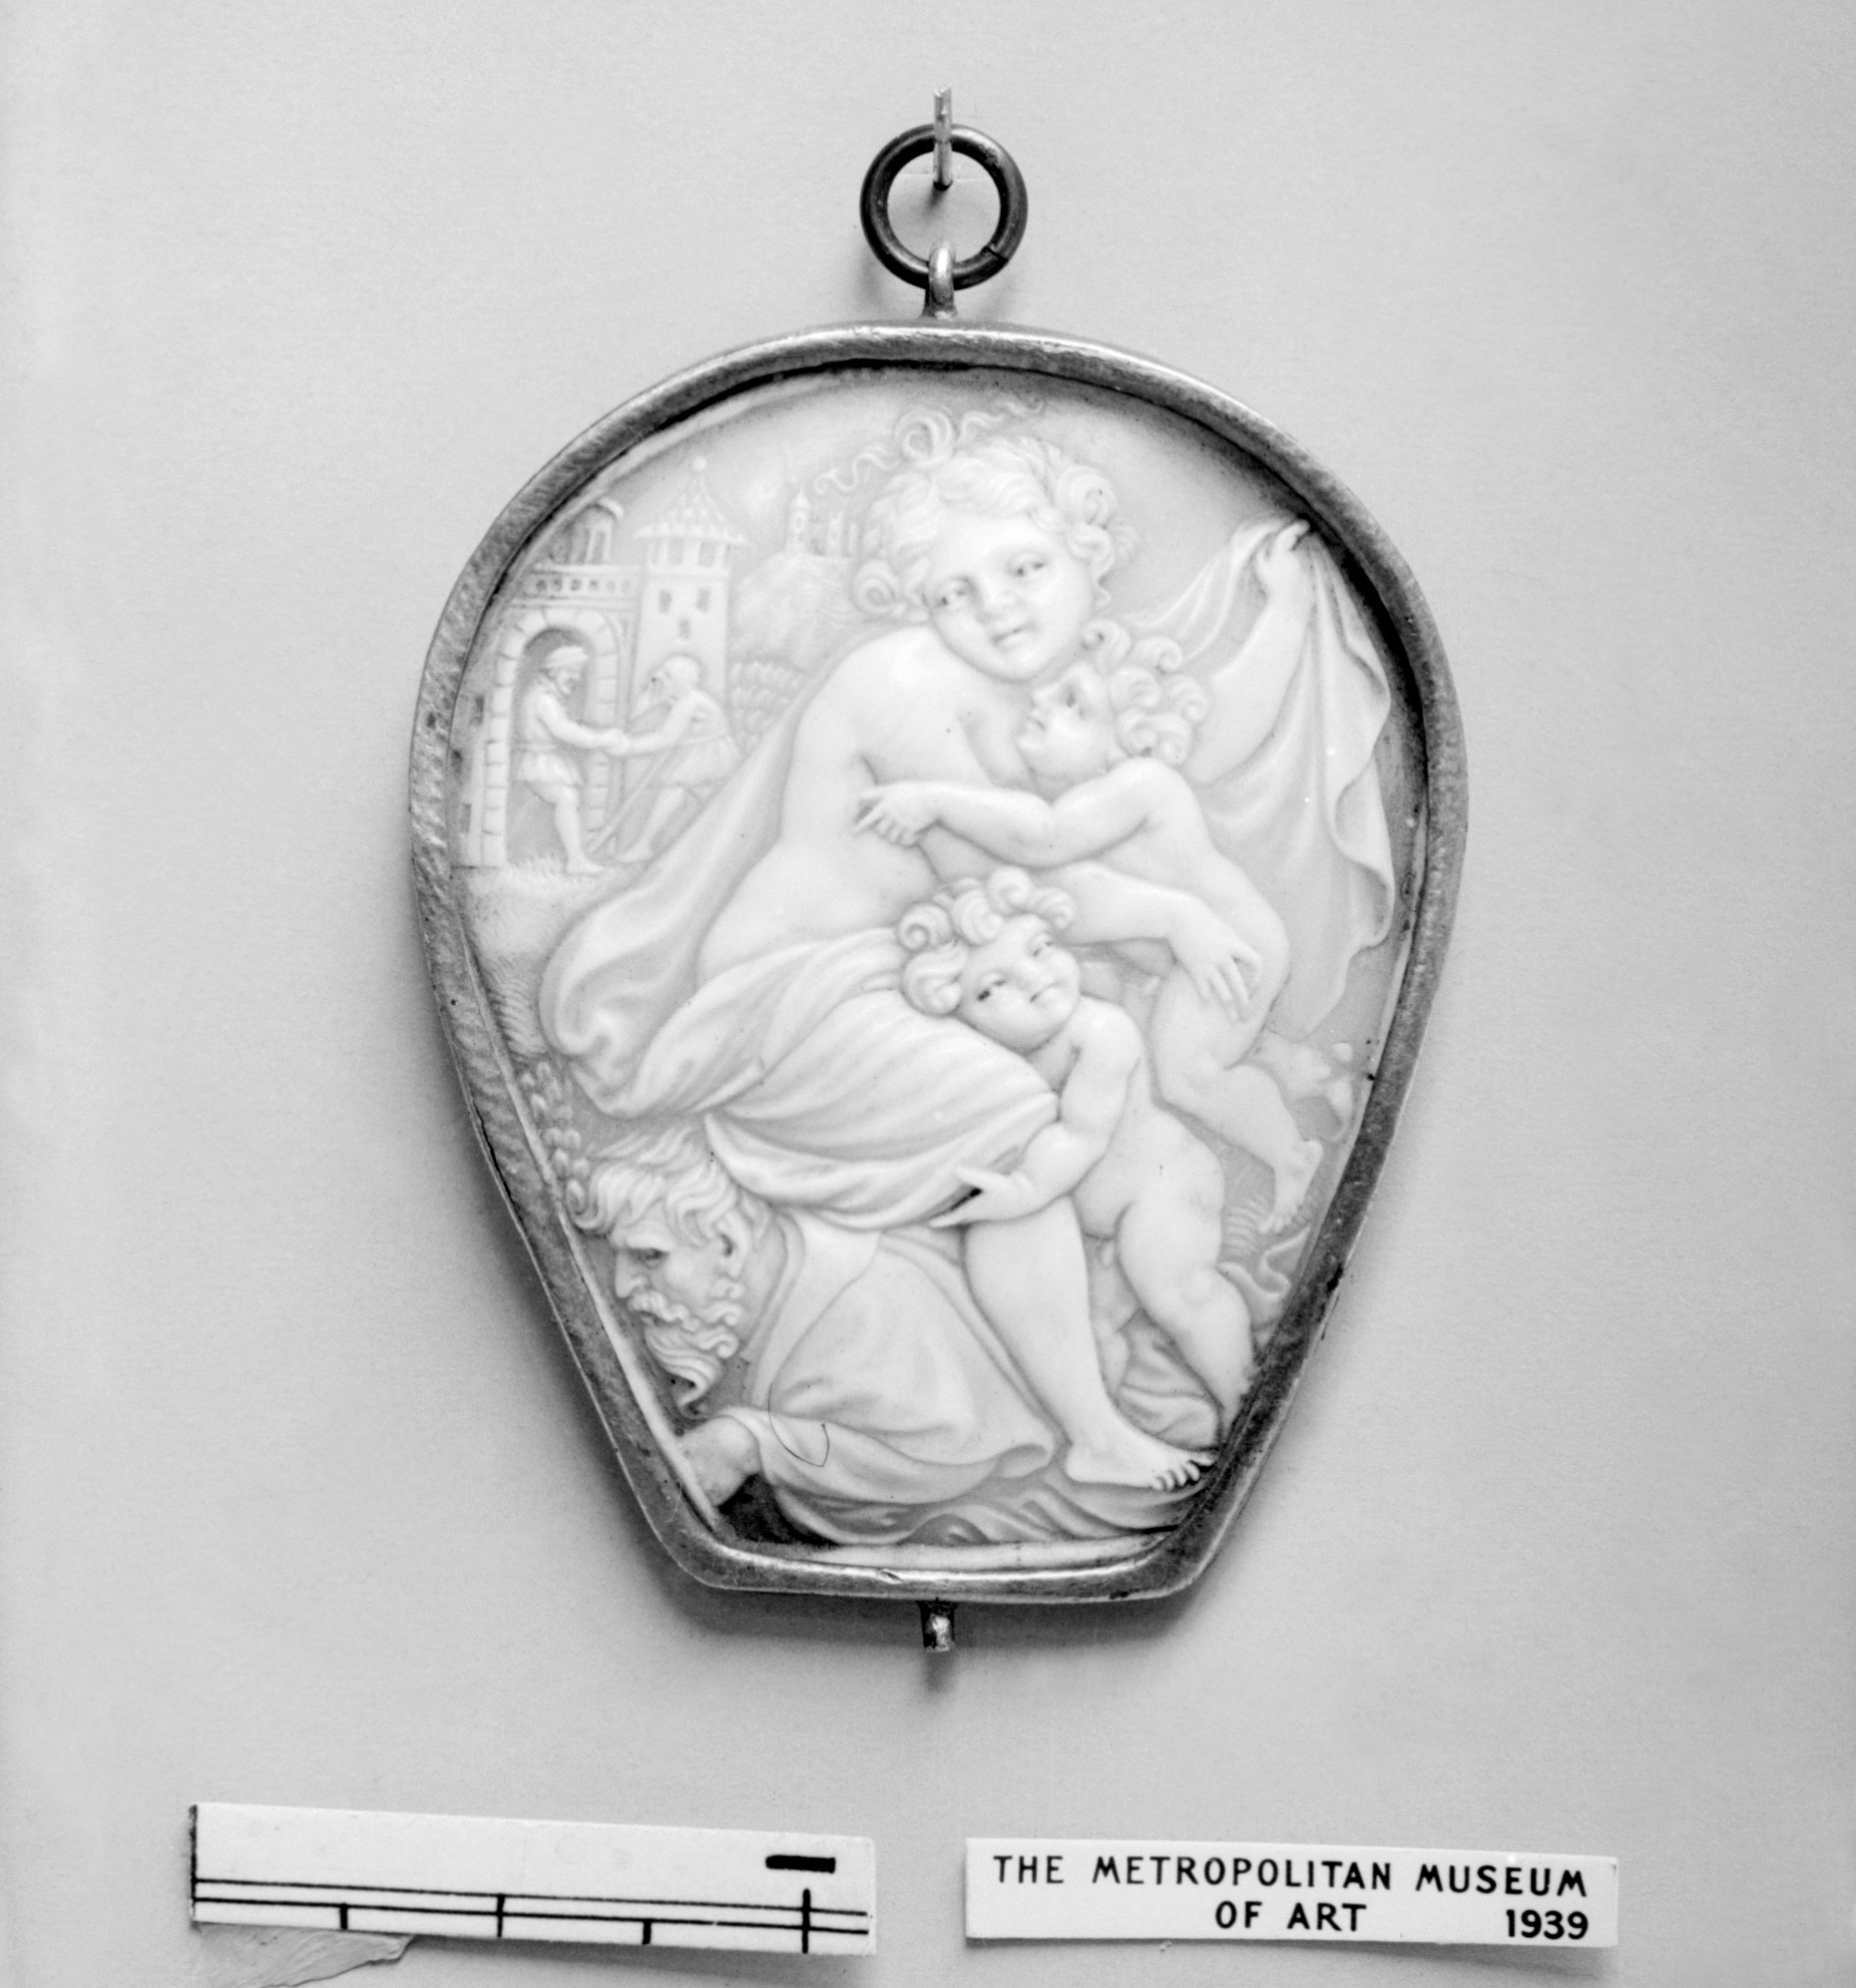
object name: cameo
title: Unidentified mythological subject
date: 1601-1700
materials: shell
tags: mythology,children,men,women